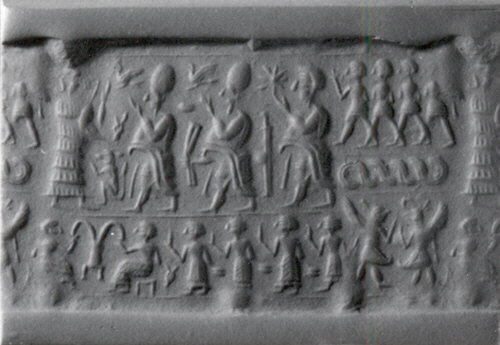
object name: cylinder seal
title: Cylinder seal and modern impression: above, royal figures approaching a suppliant goddess; below, a banquet scene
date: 1720-1650 BCE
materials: mineral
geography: syria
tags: goddess